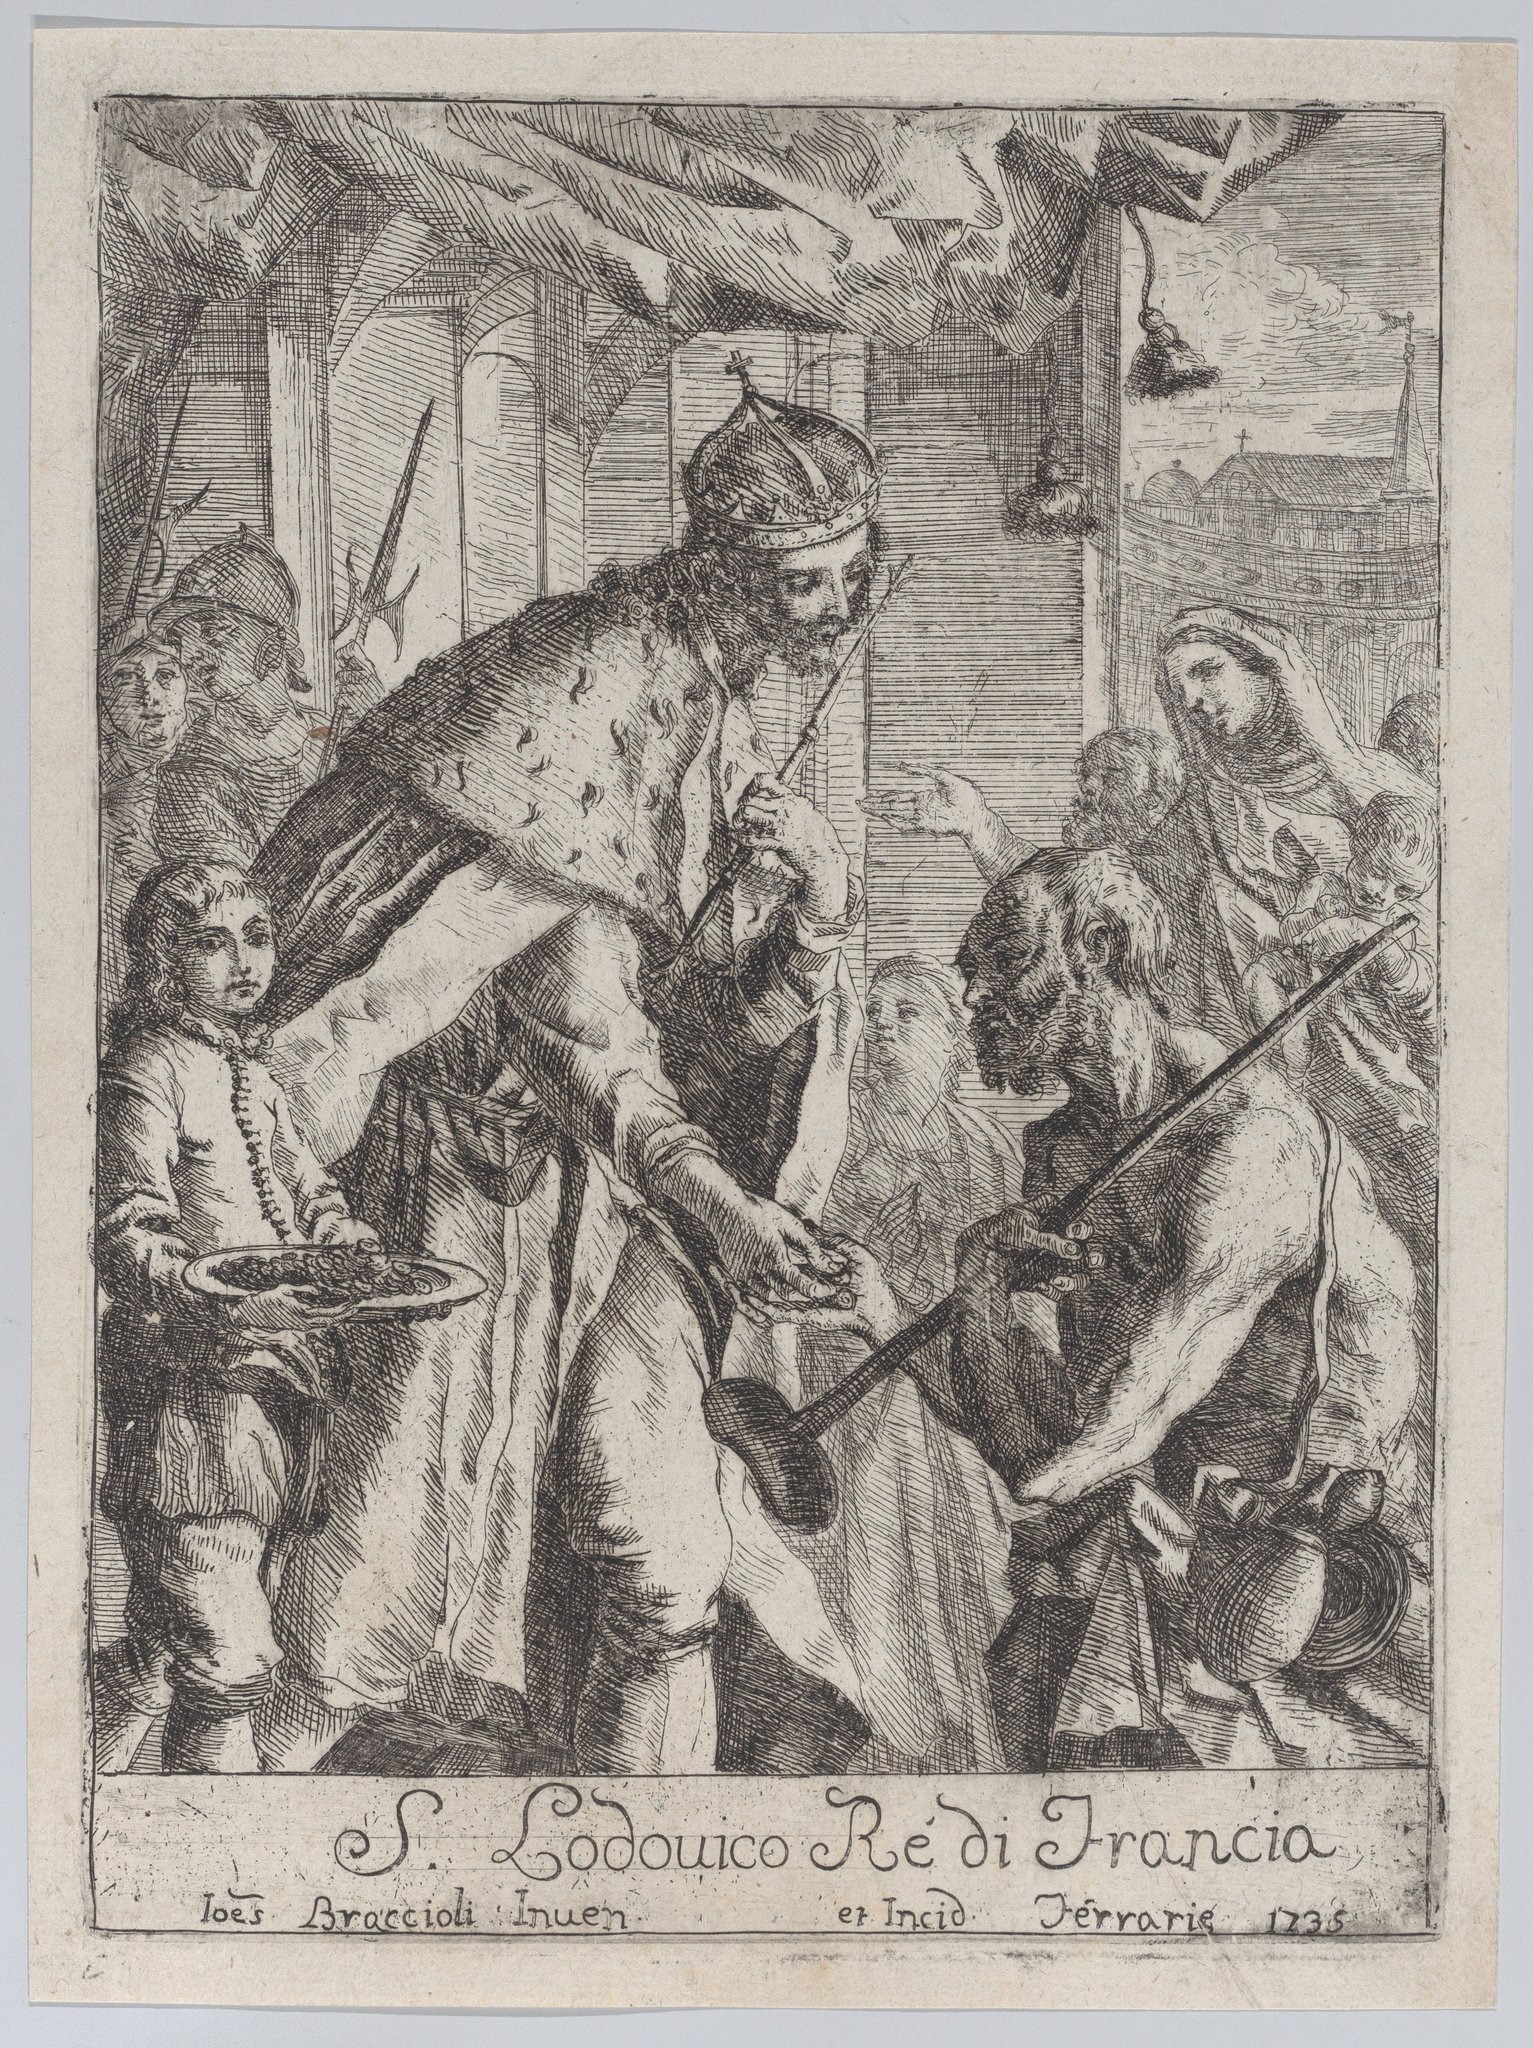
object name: print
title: Saint Louis giving alms to the poor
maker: giovanni francesco braccioli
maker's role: artist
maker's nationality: italian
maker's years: 1698-1762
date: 1735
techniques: etching